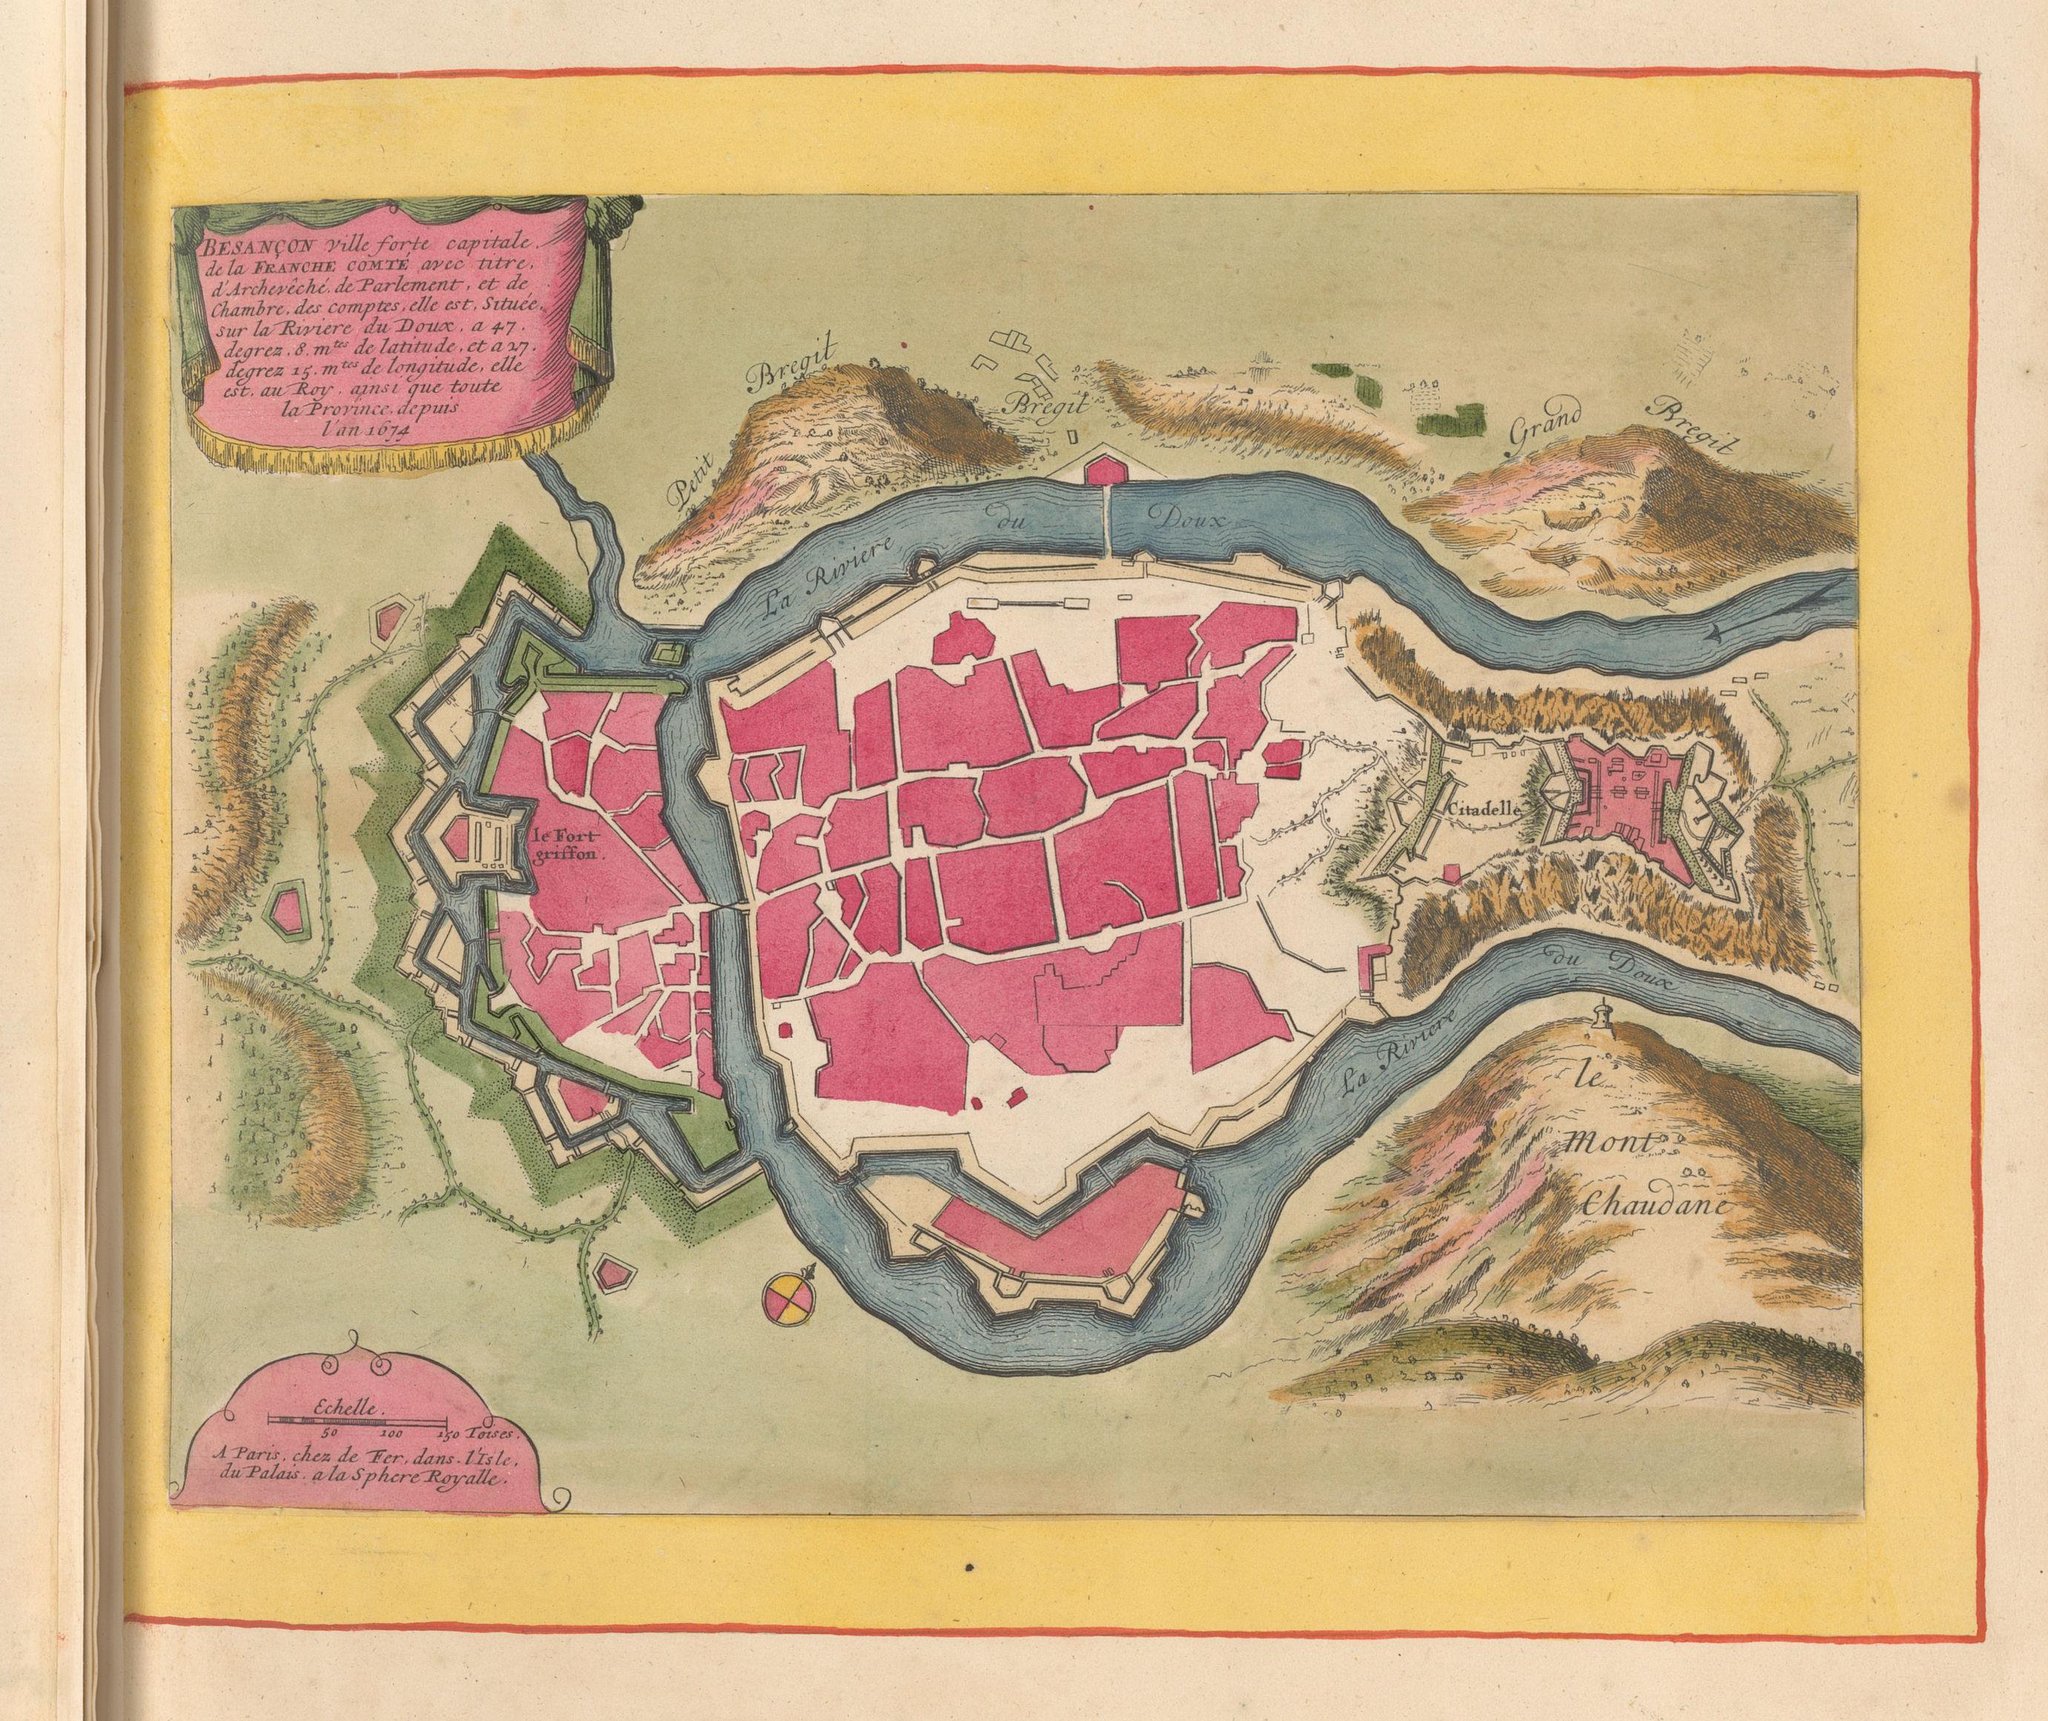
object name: print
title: Besançon, ville forte capitale de la Franche Comté (...)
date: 1690-1700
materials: paper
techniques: engraving, hand coloring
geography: the hague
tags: maps of cities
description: Kaart gebruikt in: Fer, Nicolas de. Les forces de l'Europe. 8 dln. Parijs: Nicolas de Fer, 1690-1695. Mortier, Pieter. Les forces de l'Europe. 10 dln. Amsterdam: Pieter Mortier, ca. 1700.